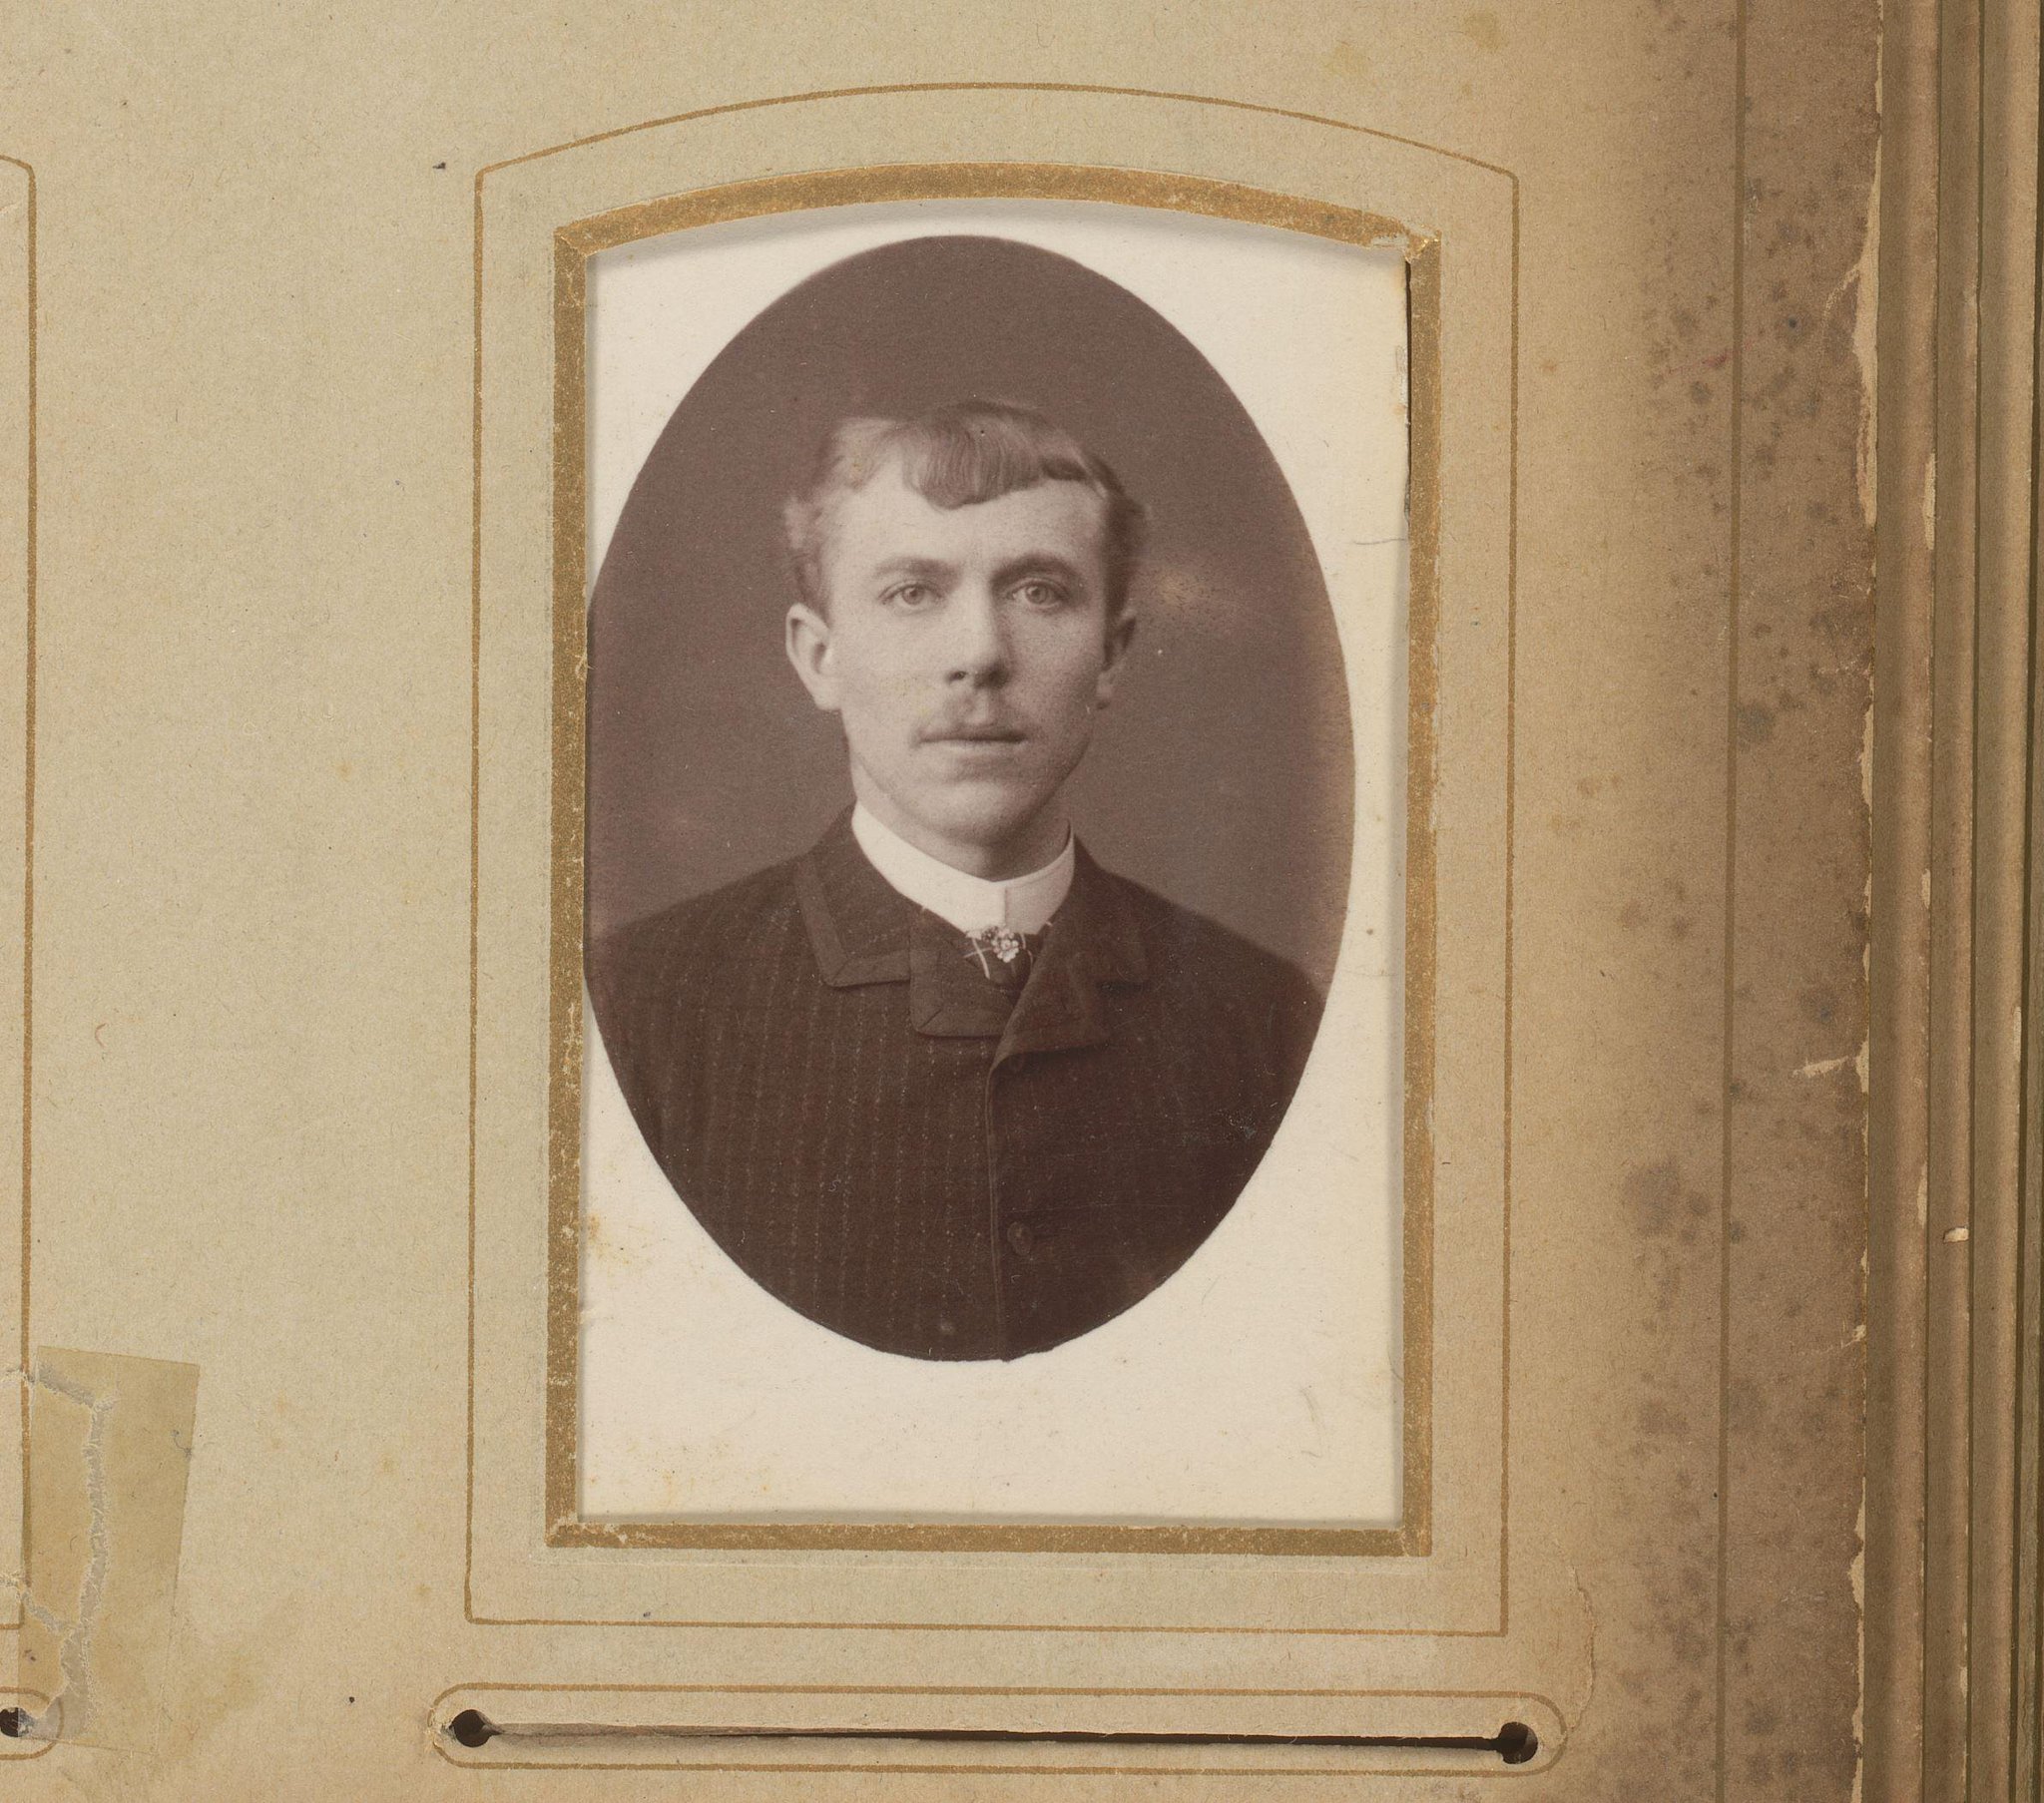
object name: photograph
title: Portret van een man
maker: carl froehlich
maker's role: fotograaf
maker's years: 1854-1902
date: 1888-1893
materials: cardboard, celluloid, photographic support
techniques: albumen print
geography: antwerp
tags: historical persons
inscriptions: inscription: ‘Photographie/ Carl Froehlich/ Rue de la commune. 20/ ANVERS/ LES CLICHÉS SONT CONSERVÉS.’